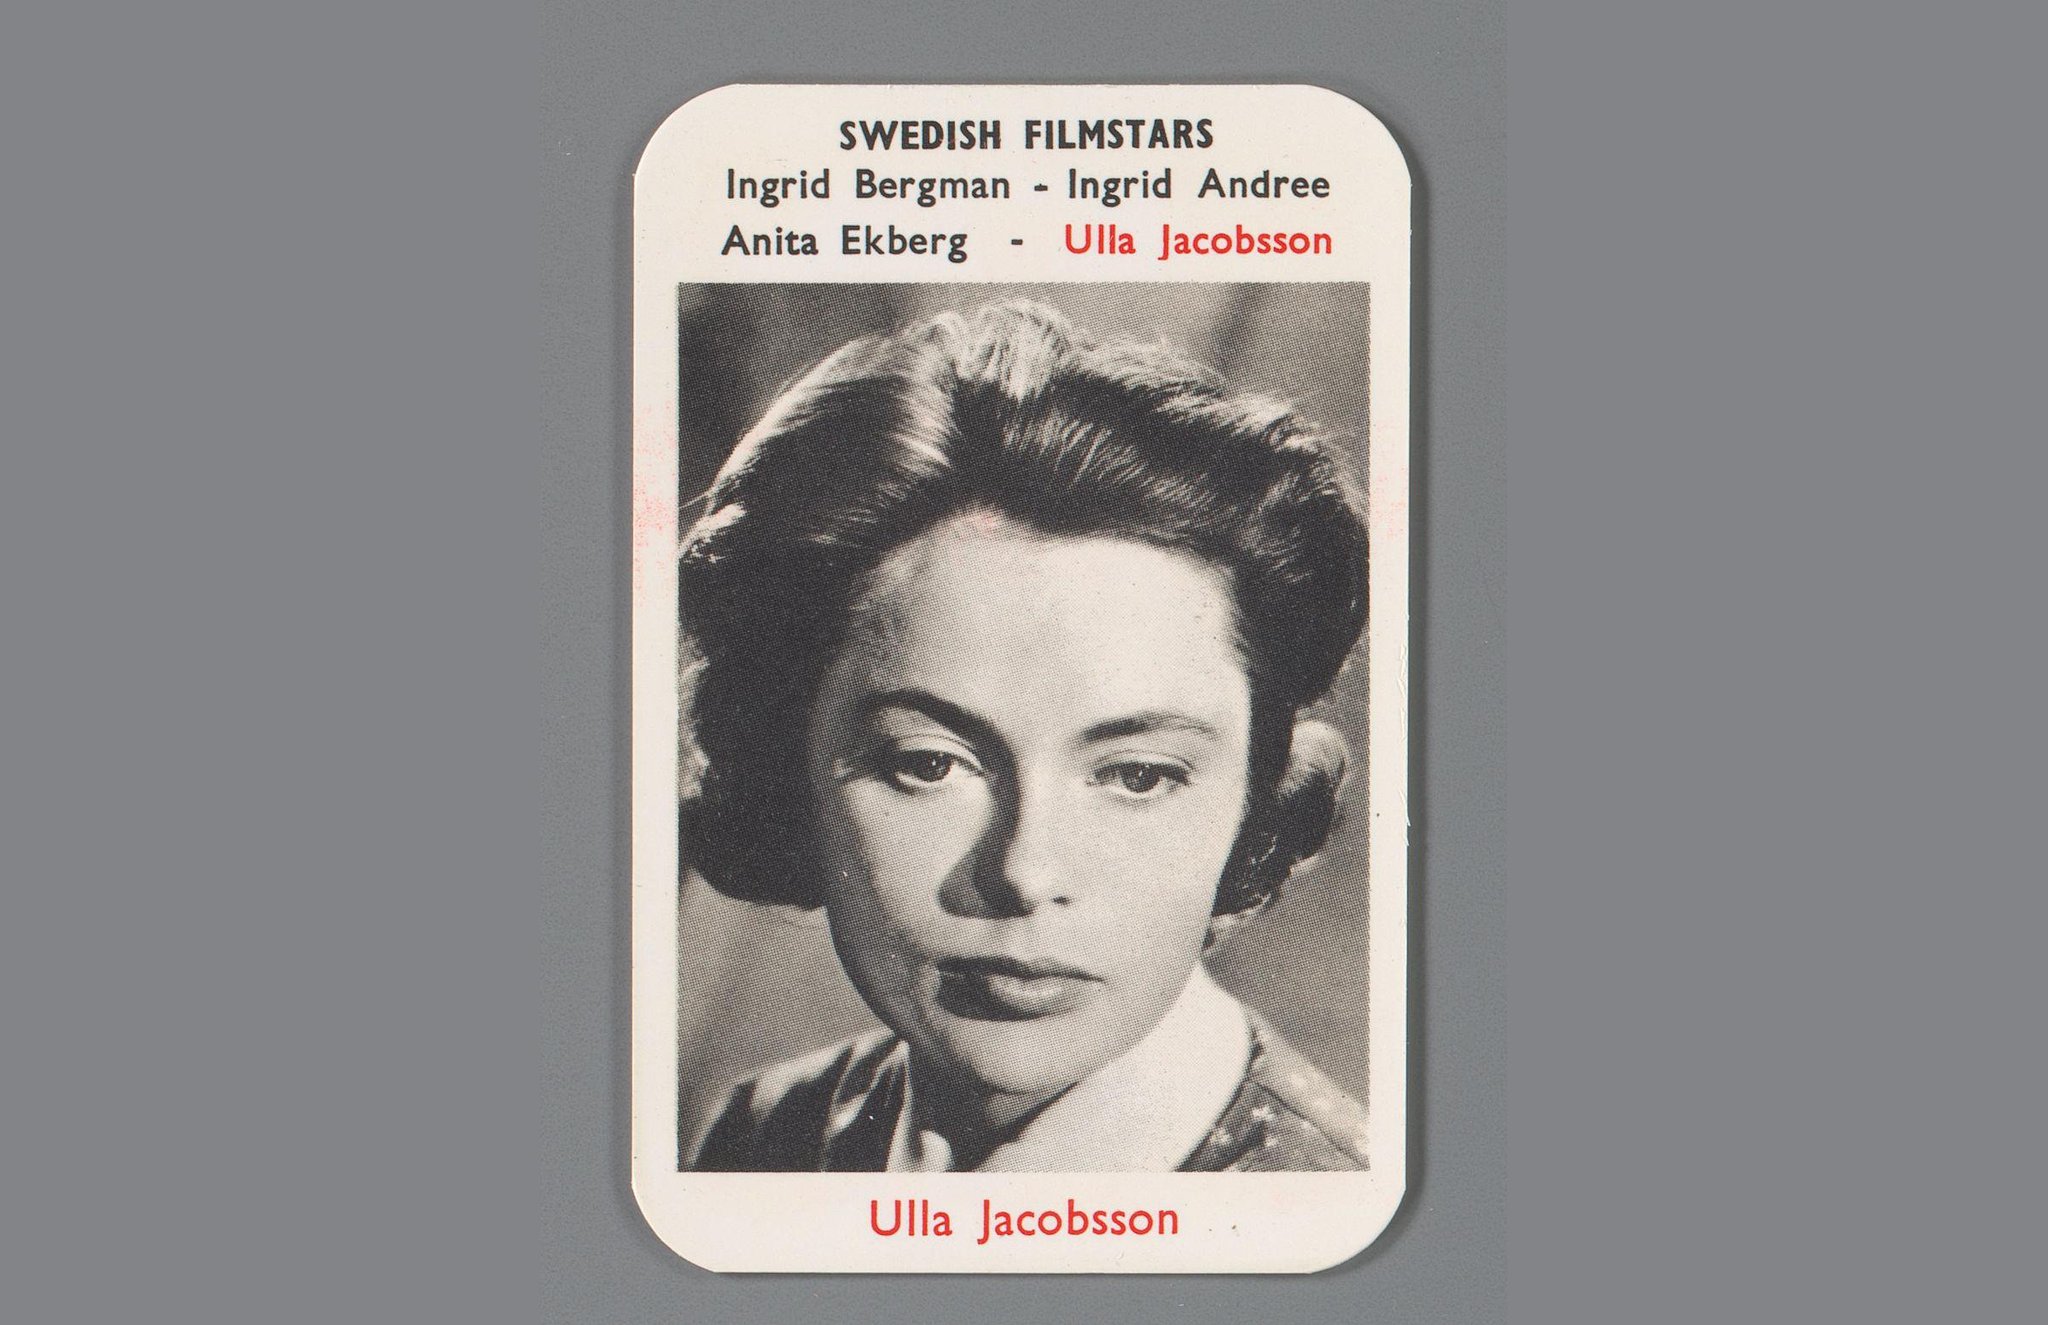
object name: playing card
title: Portret van Ulla Jacobsson; onderdeel van het kwartet Swedish Filmstars uit een kwartetspel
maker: Anonymous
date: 1960-1970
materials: paper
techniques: autotype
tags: vienna, portrait of actor, actress